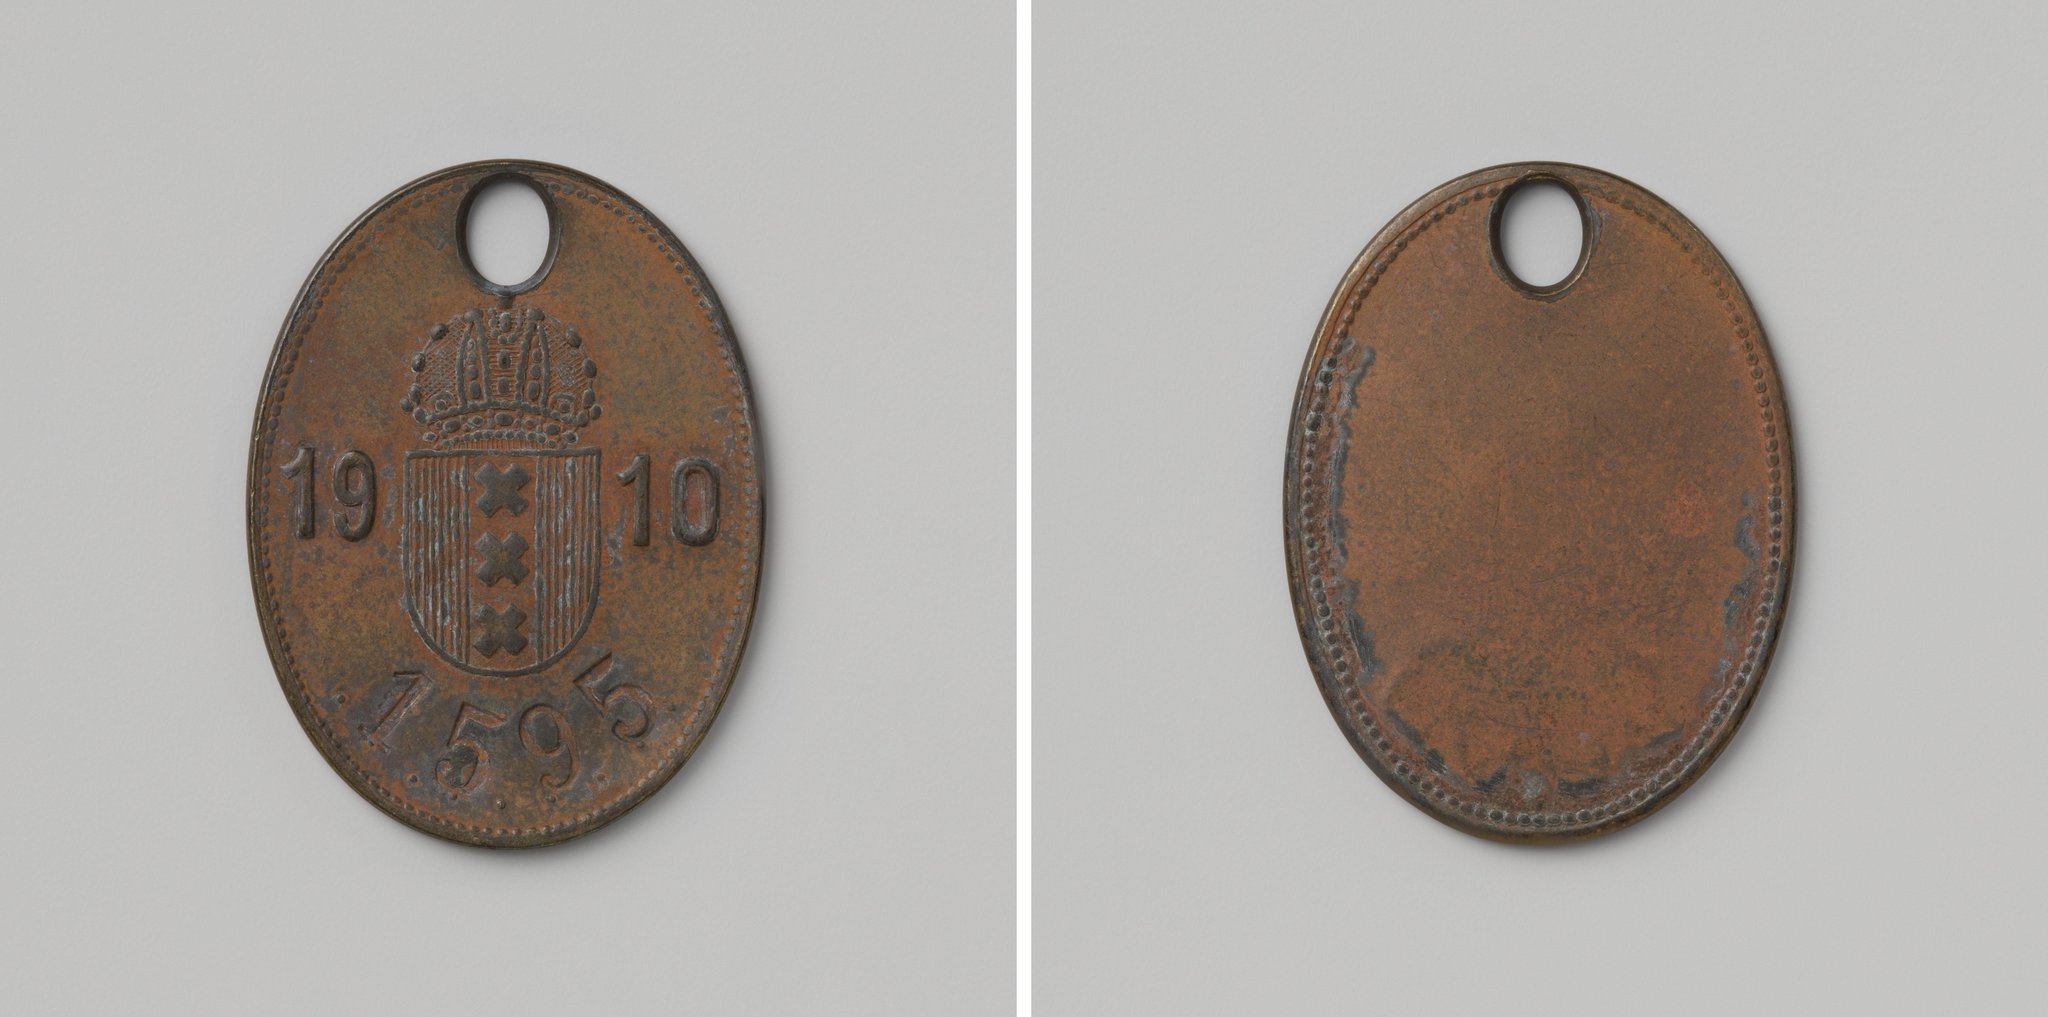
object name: hondenbelastingloodje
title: Stad Amsterdam, loodje met no. 1595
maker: Anonymous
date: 1910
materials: brass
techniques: striking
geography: amsterdam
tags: amsterdam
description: eenzijdig, ovaal loodje met gat erin. Voorzijde: gekroond wapenschild tussen jaartal boven cijfer 1595. Keerzijde: blanco